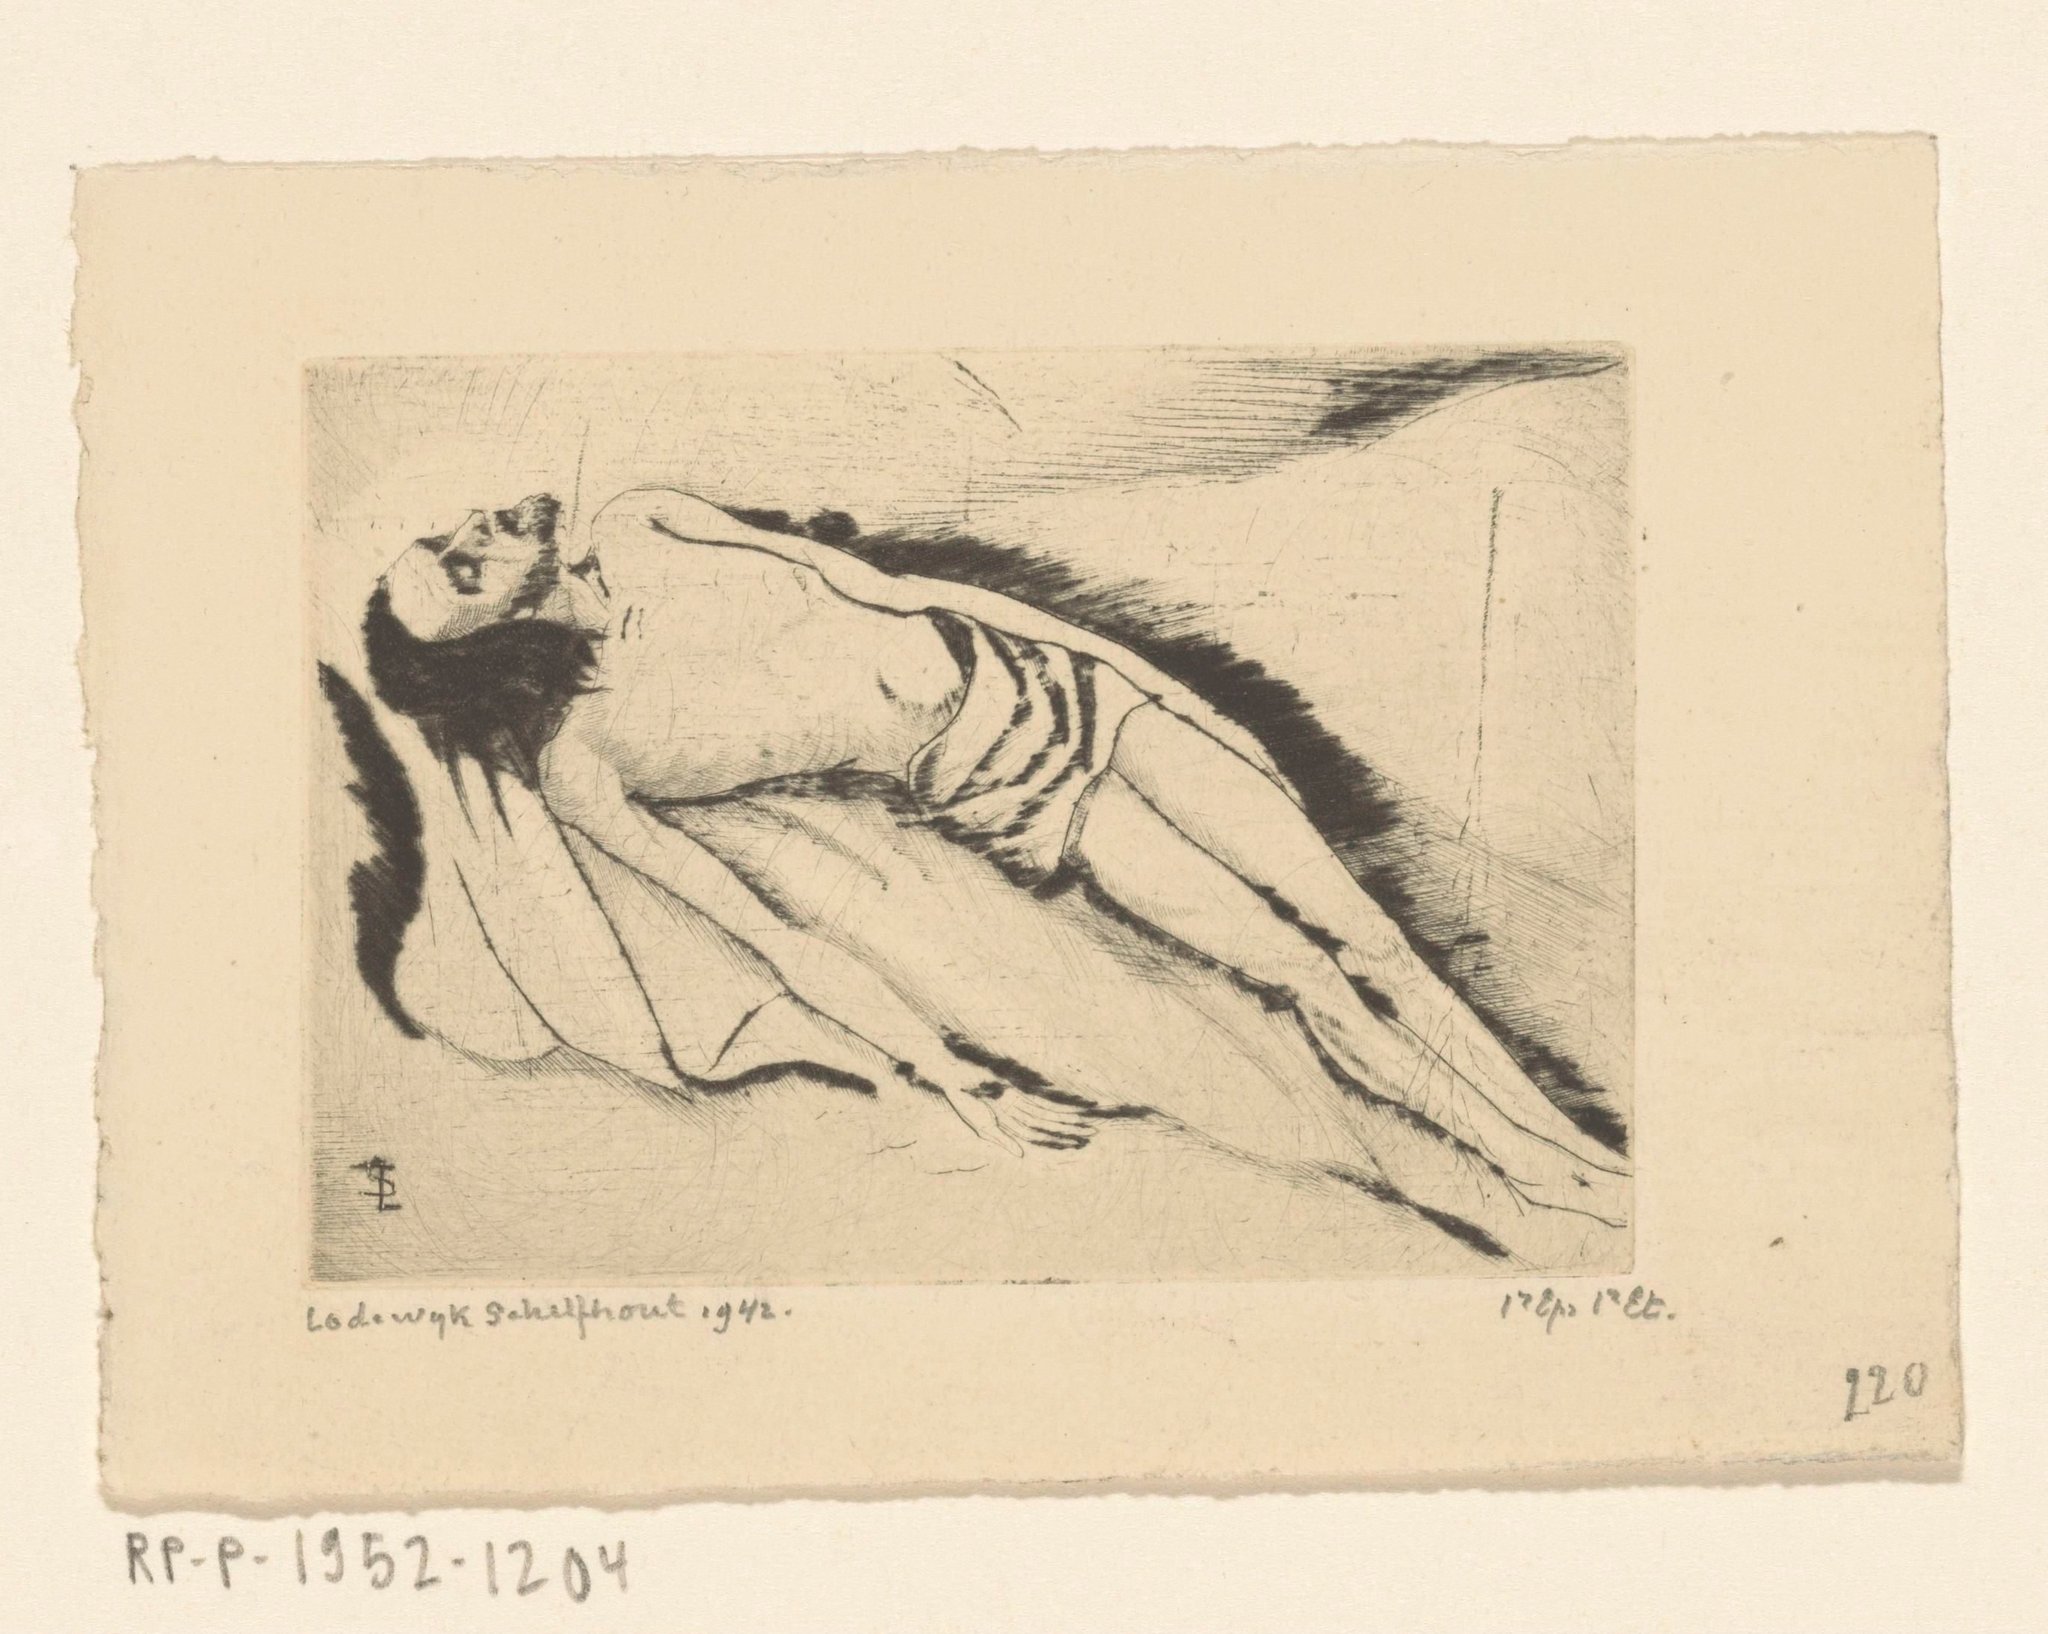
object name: print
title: Le Christ mort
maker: lodewijk schelfhout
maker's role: draughtsman, print maker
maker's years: 1881-1943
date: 1942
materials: paper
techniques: drypoint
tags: christ dead ~ particularities of crucifixion scenes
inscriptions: collector's mark: Lugt 5i, collector's mark: Lugt 2228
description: Het lichaam van de dode Christus, liggend op een kleed.